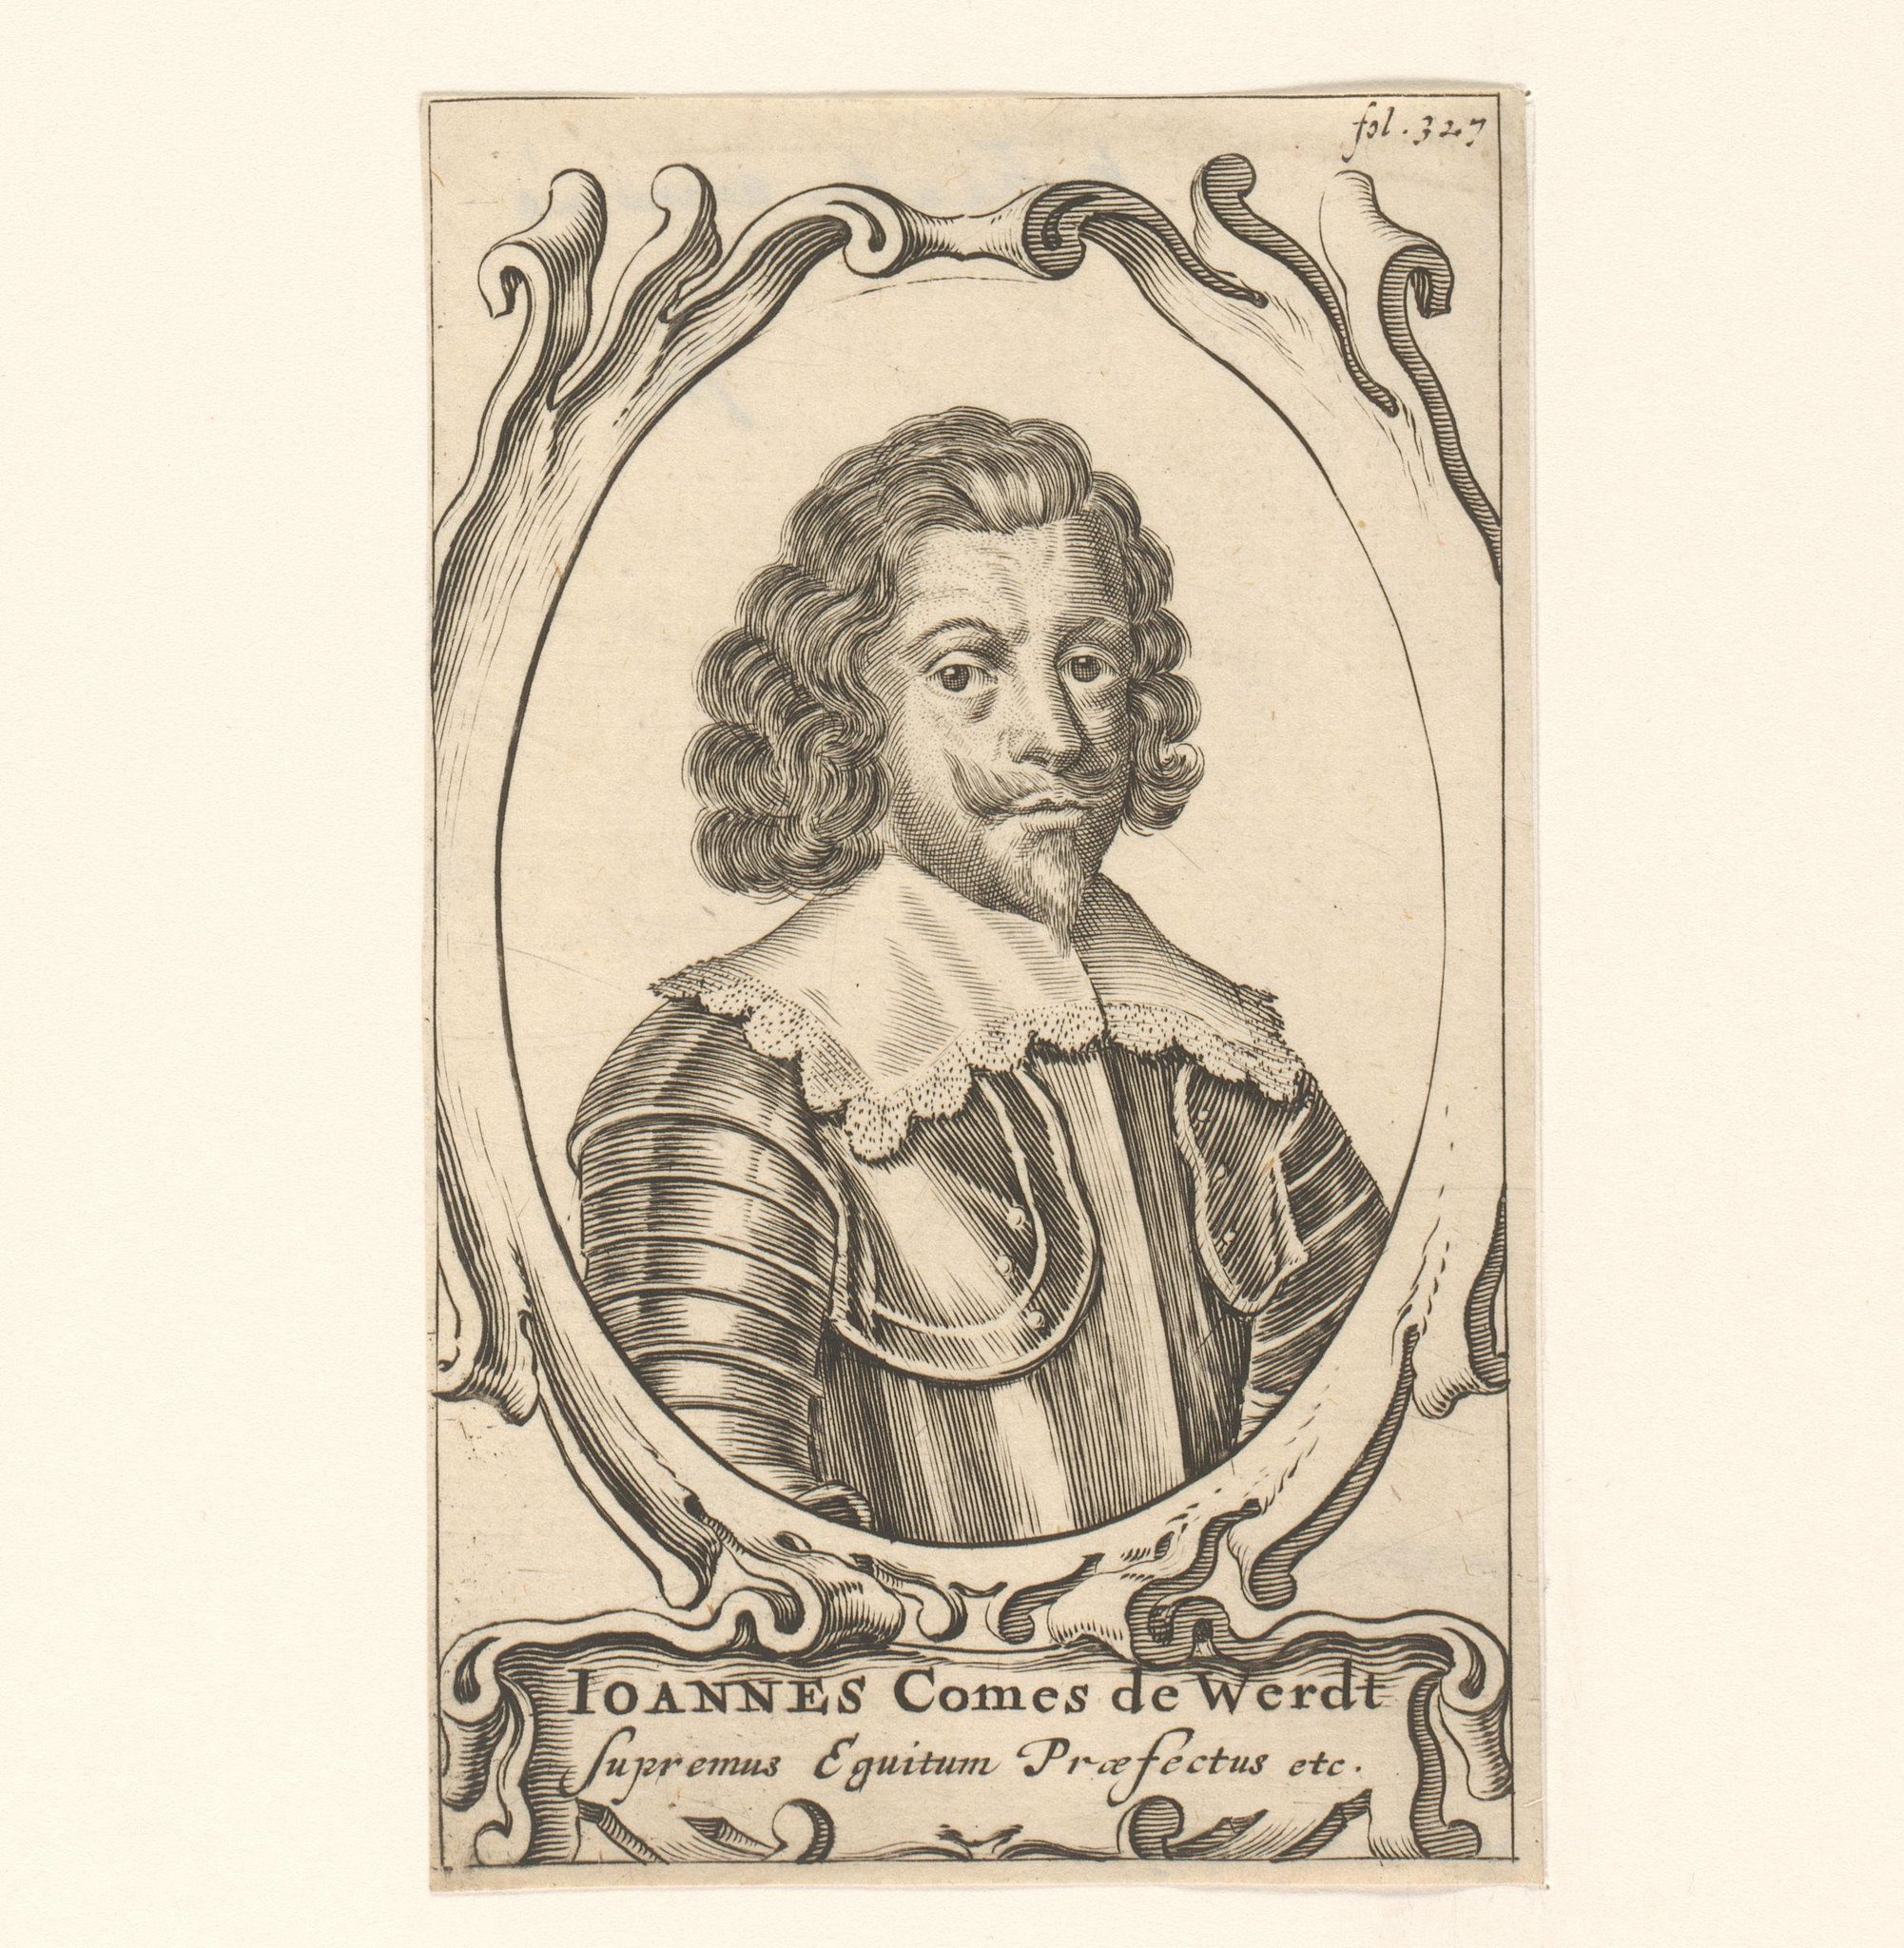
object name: print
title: Ioannes comes de Werdt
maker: Anonymous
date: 1656-1666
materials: paper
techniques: engraving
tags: earl, commander-in-chief, general, marshal, historical persons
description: Prent gebruikt in: Brachelius, Johannes Adolphus. Historia nostri temporis, dat is: geschiedenis onses tijdts, (...). Rotterdam: Andries van Hoogenhuyse, 1656. Prent in ieder geval ook gebruikt in hetzelfde boek uitgegeven door Andries van Hoogenhuyse in Nijmegen in 1659 en uitgegeven door Samuel Imbrecht in Amsterdam in 1666.